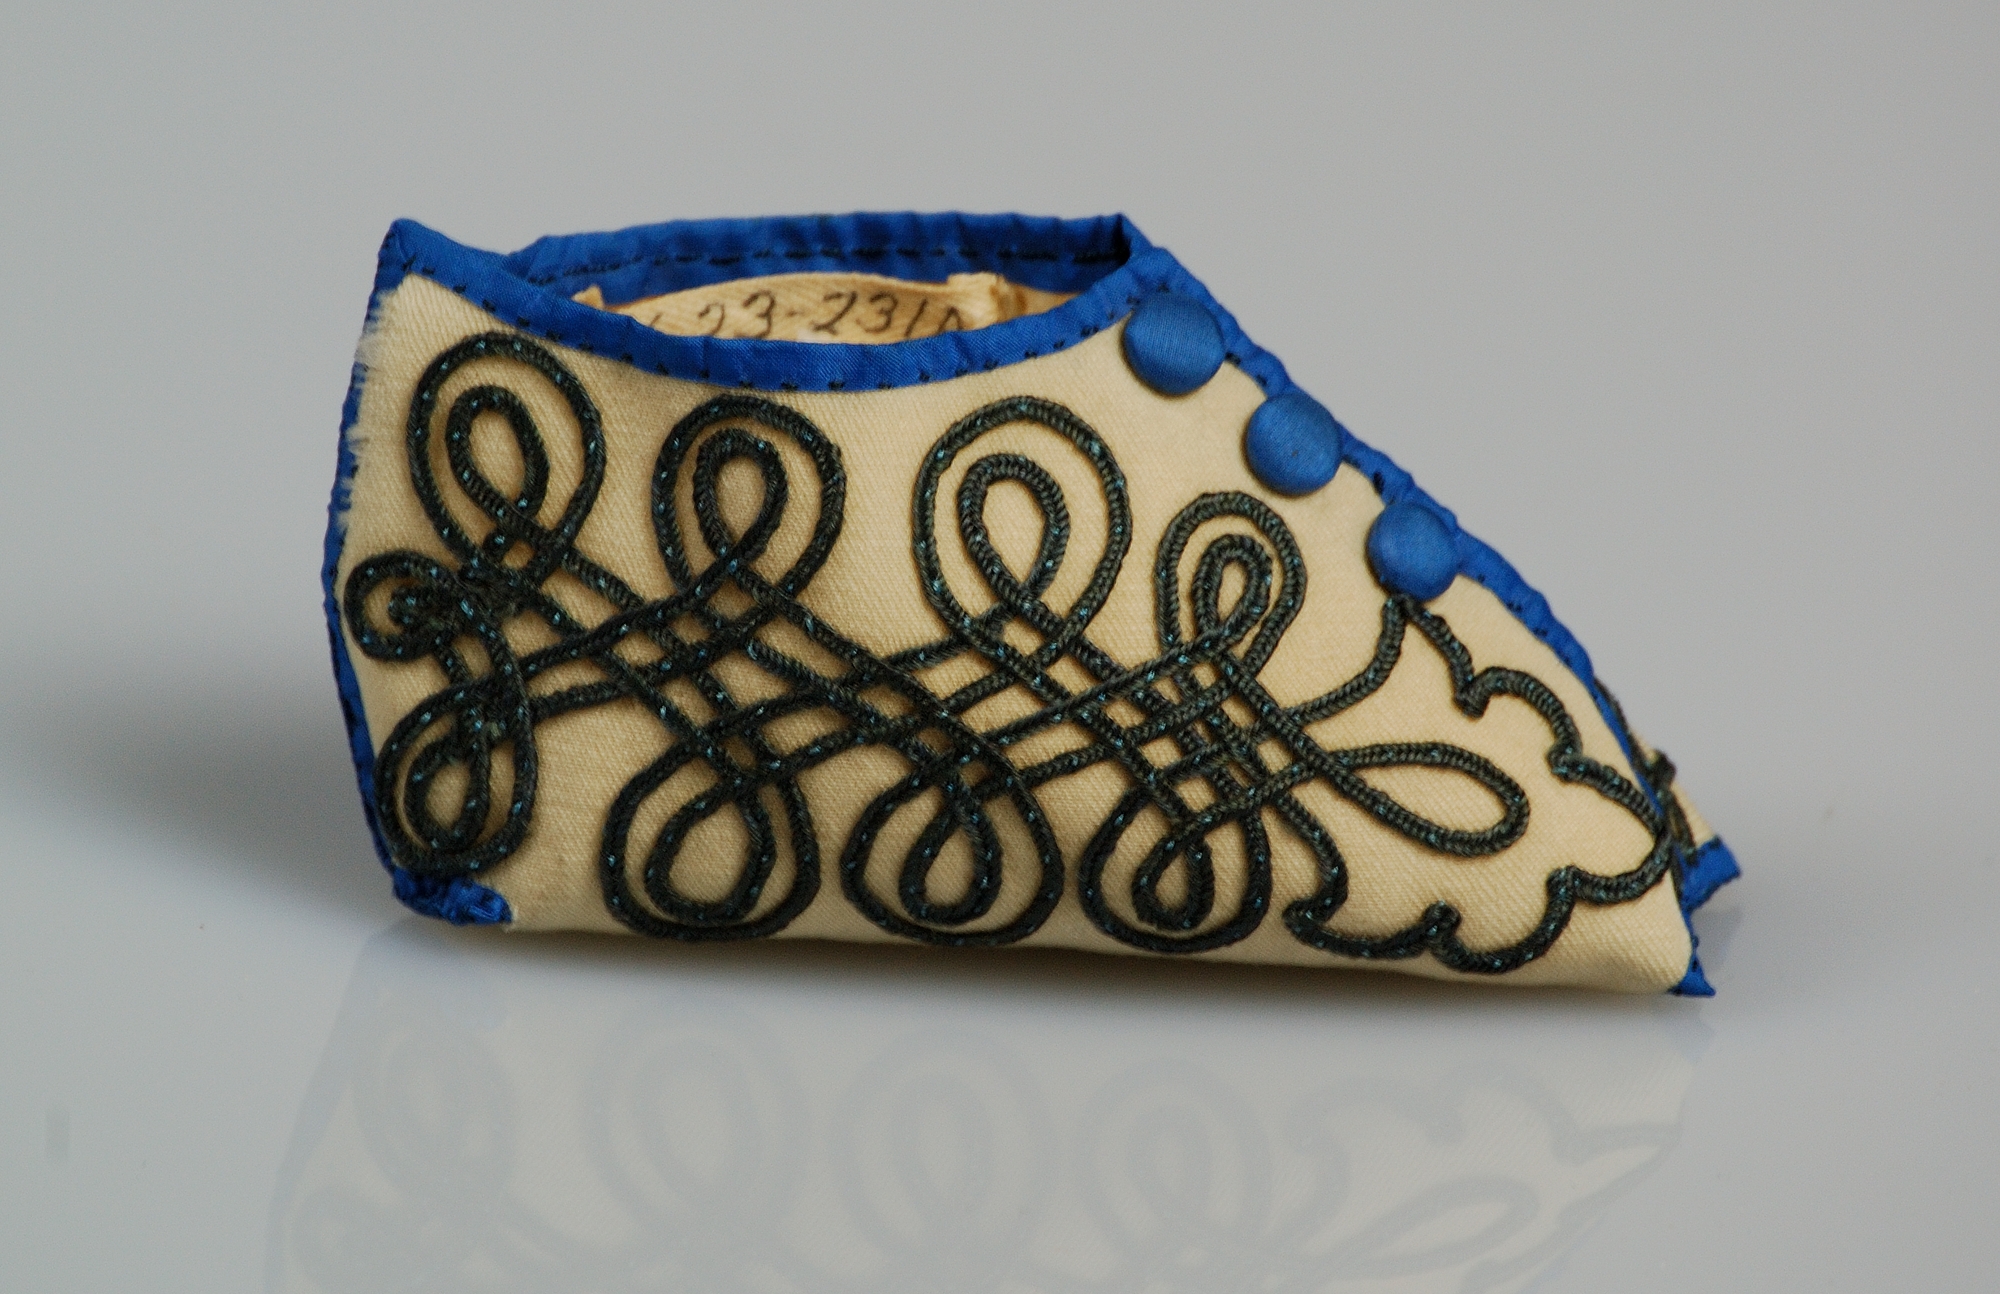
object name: bootee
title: Bootees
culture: american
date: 1870-1880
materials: silk, wool